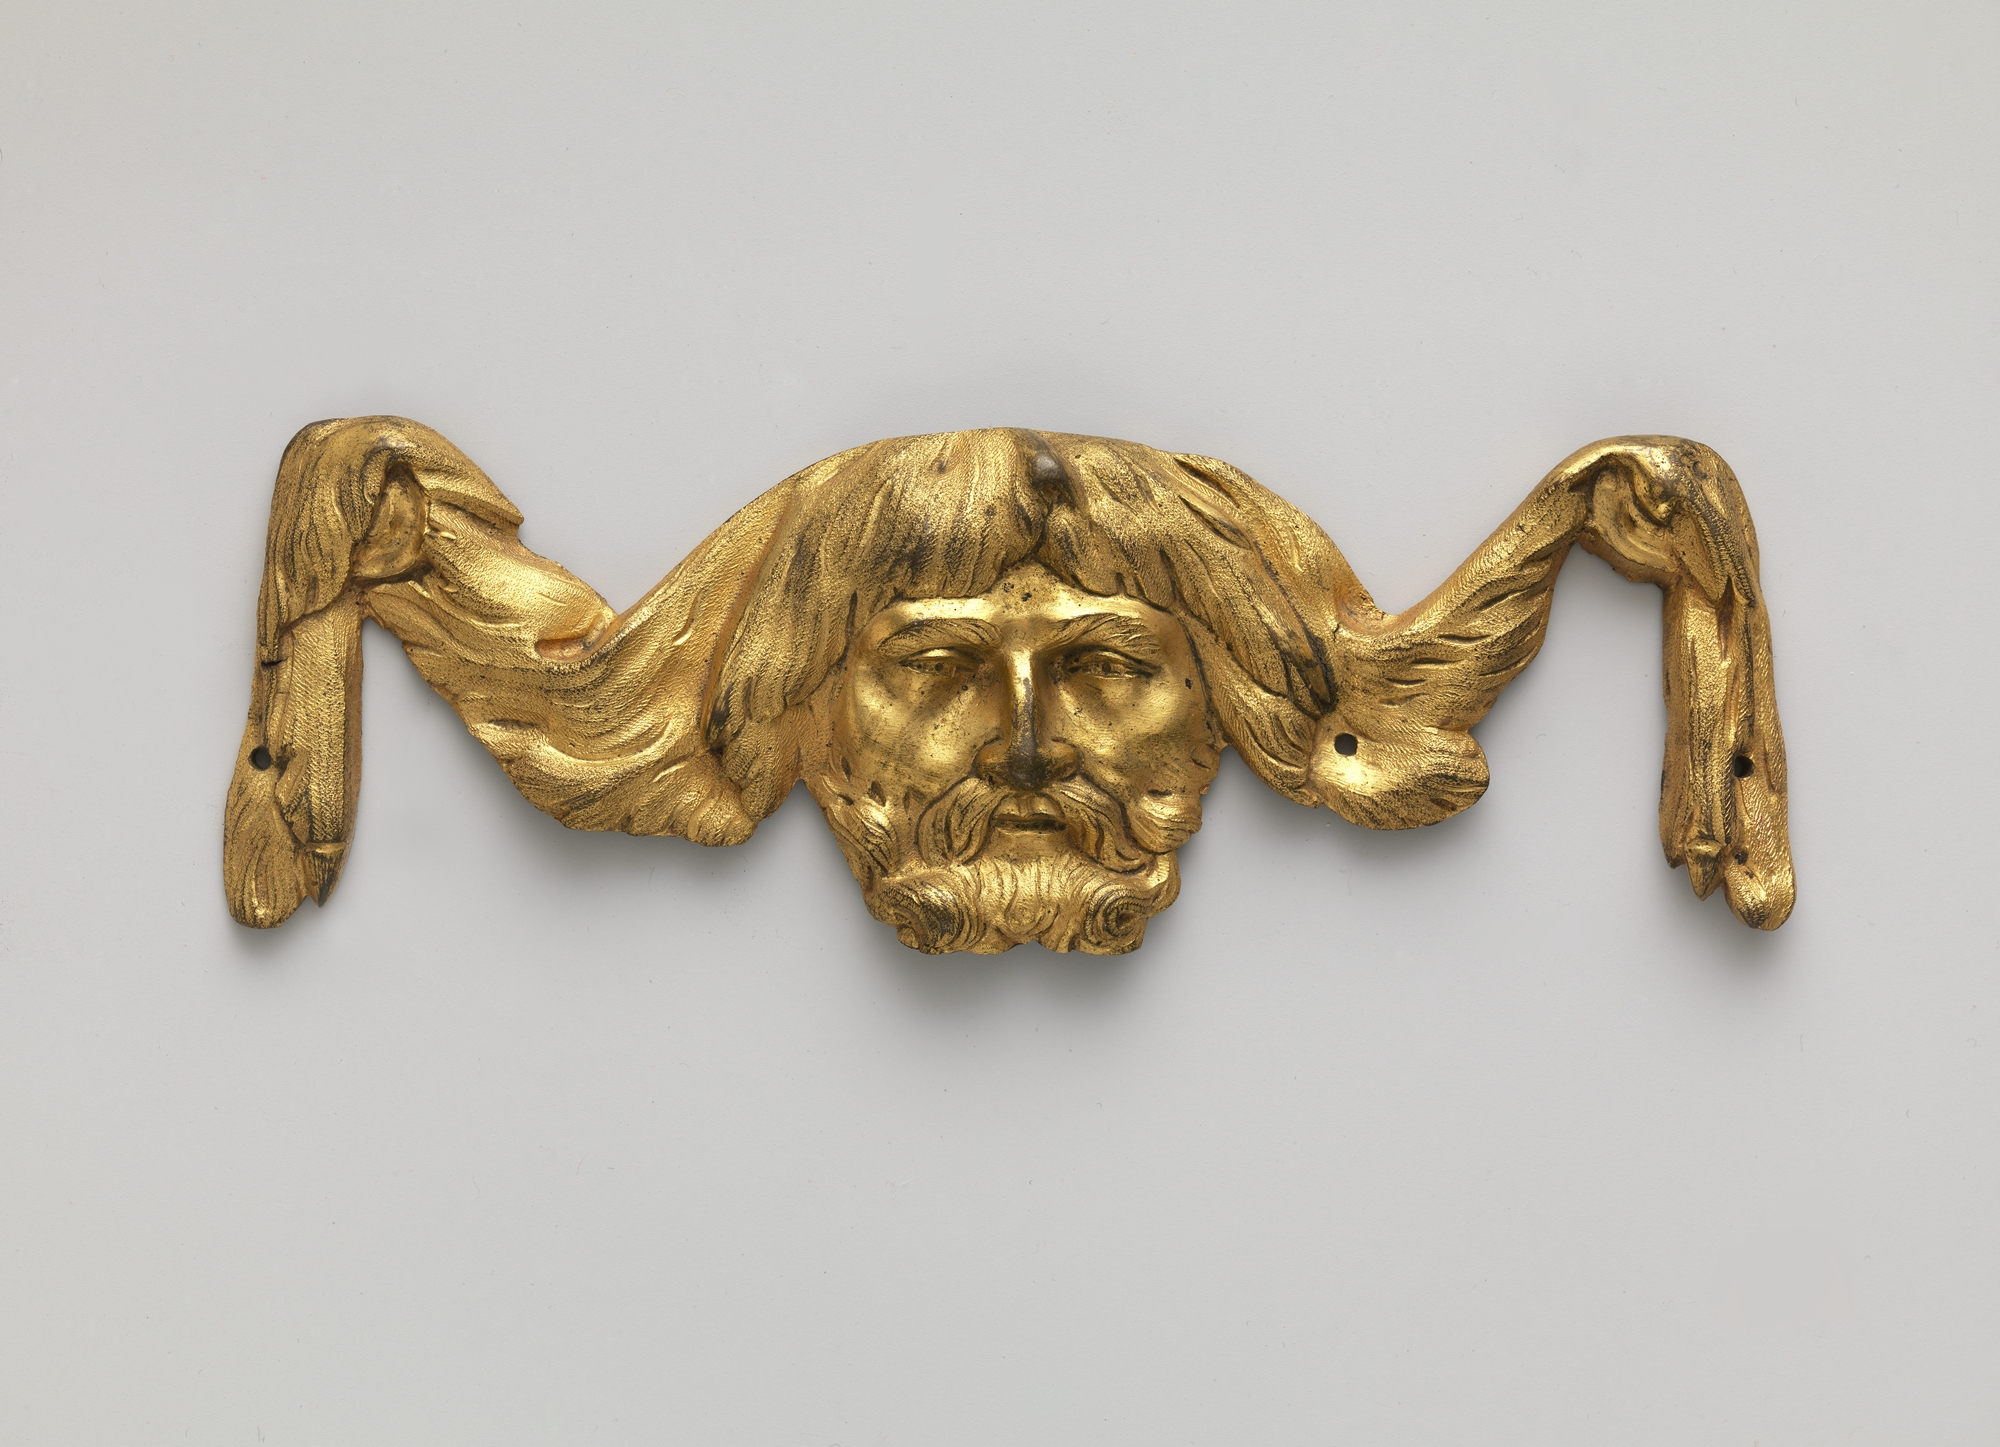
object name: clock ornament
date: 1701-1800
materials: gilt bronze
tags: faces